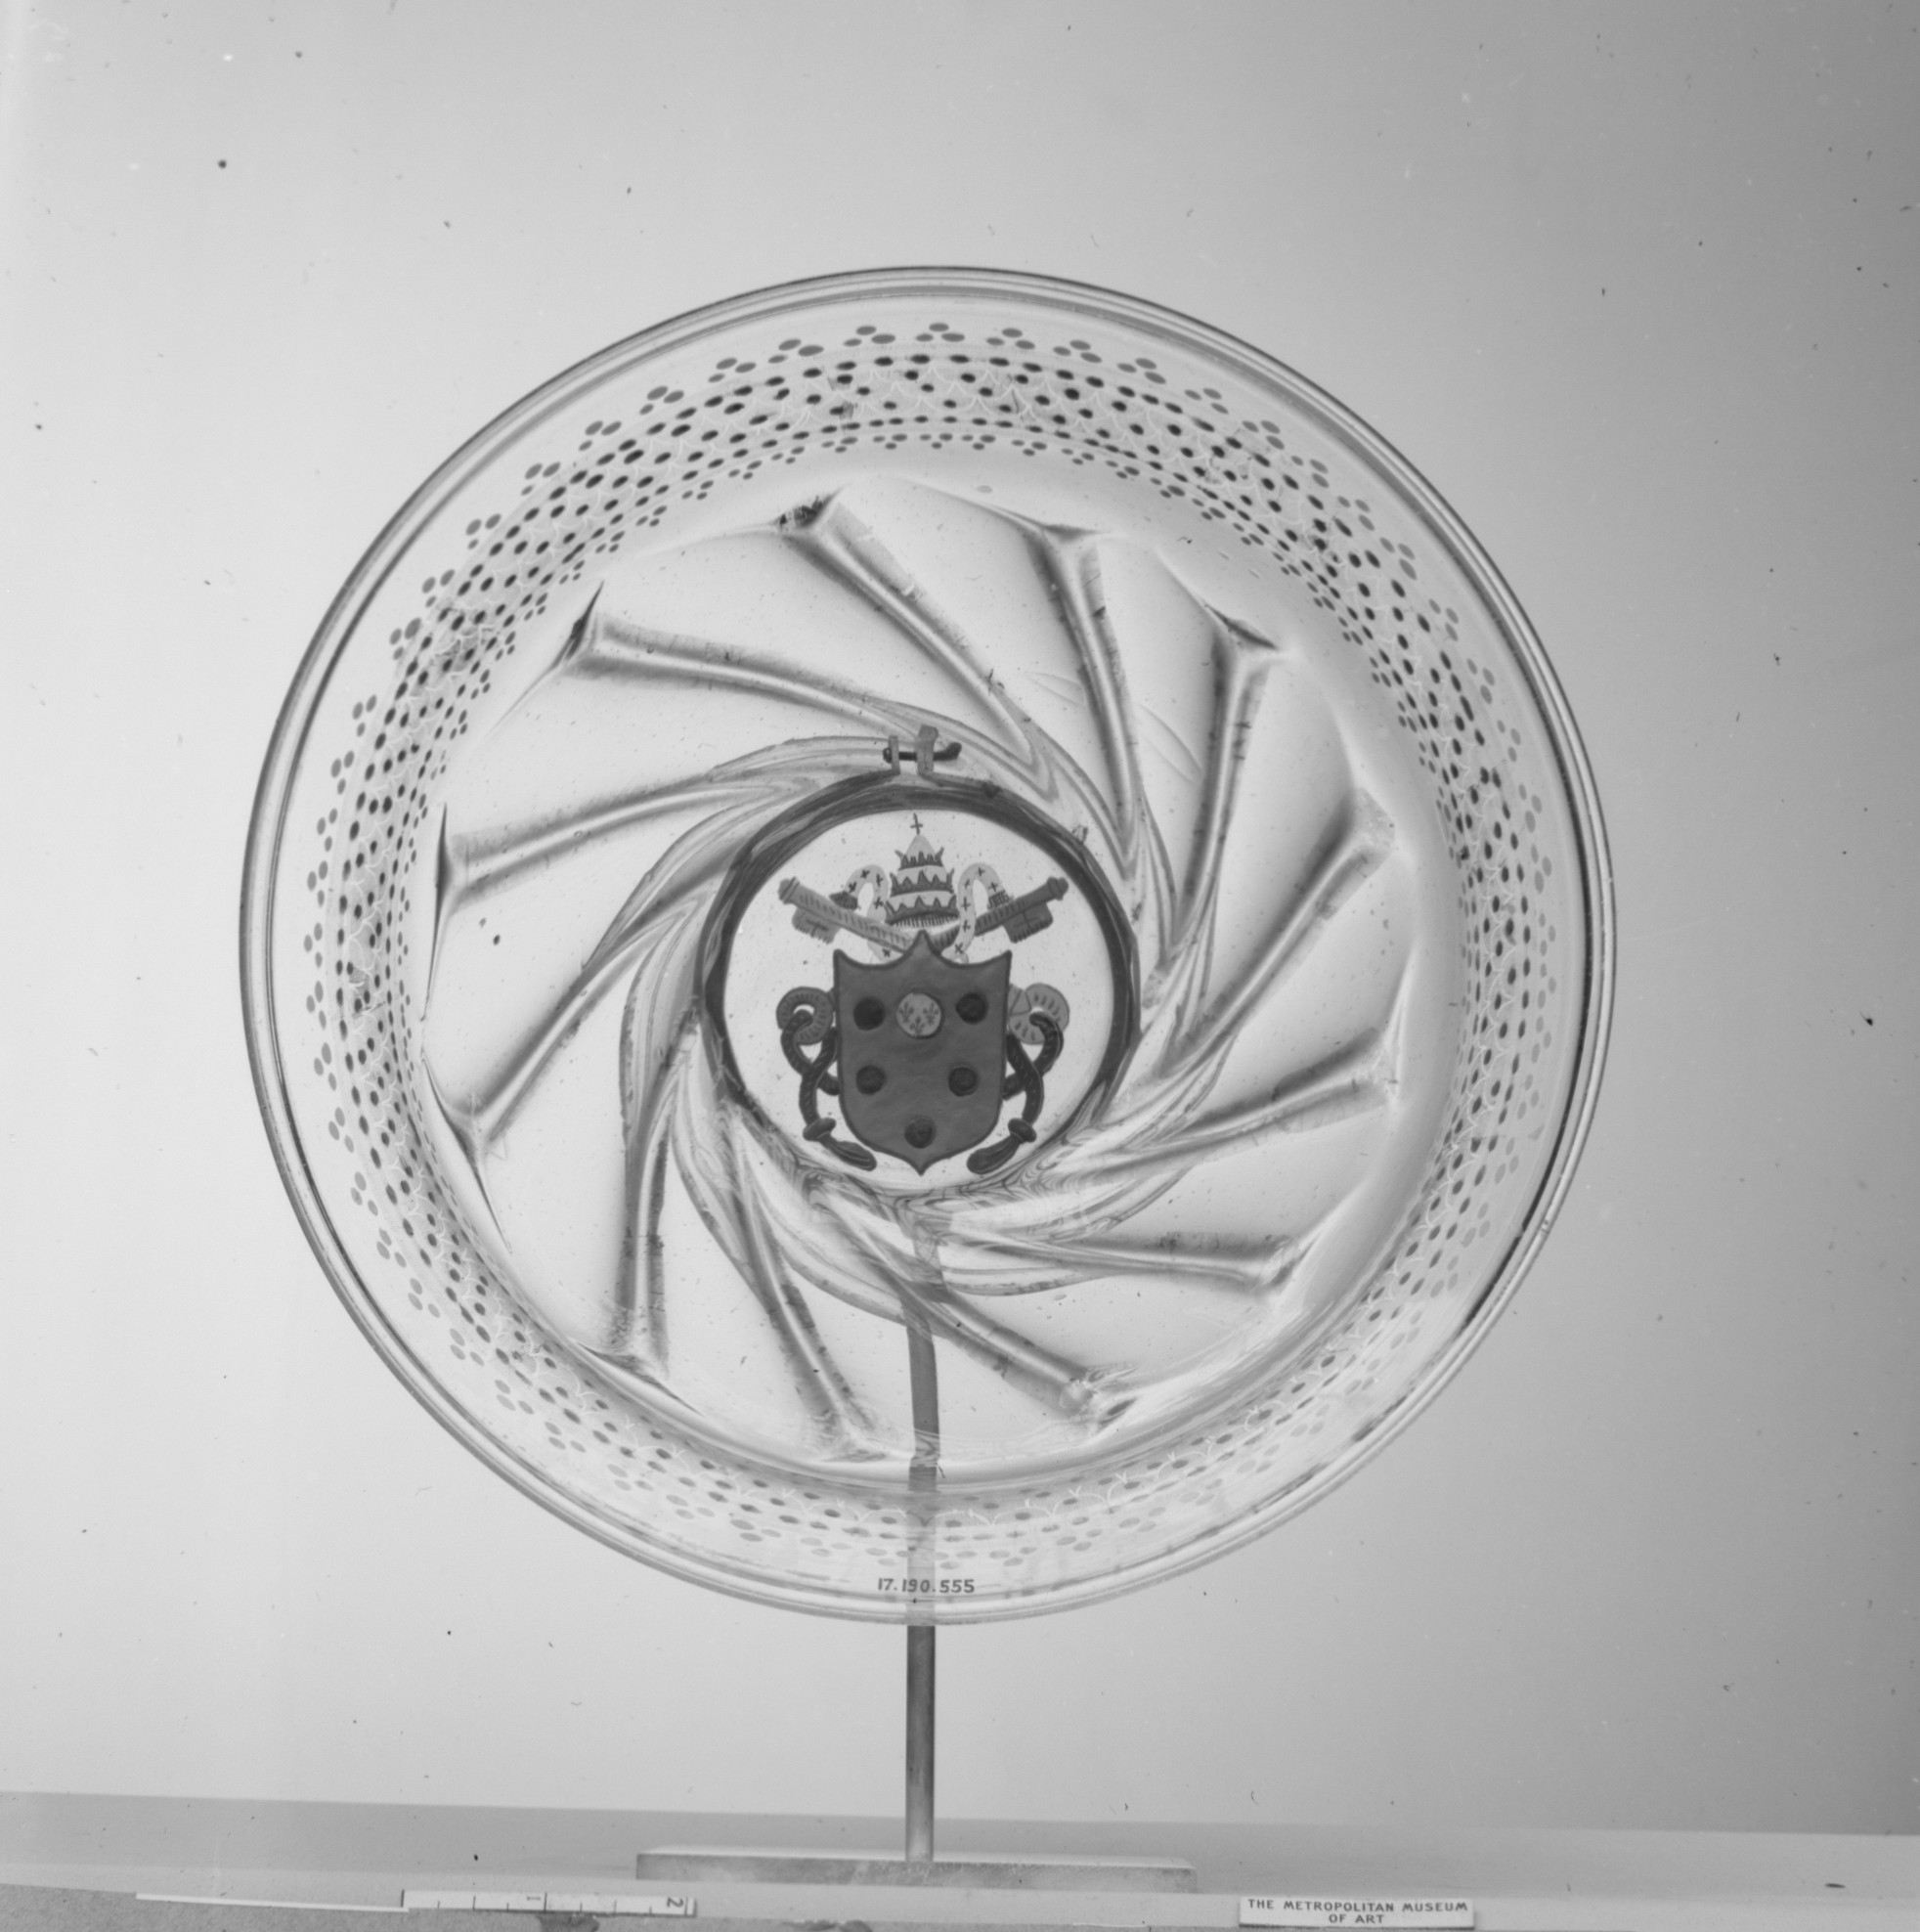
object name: tazza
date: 1501-1550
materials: glass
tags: coat of arms